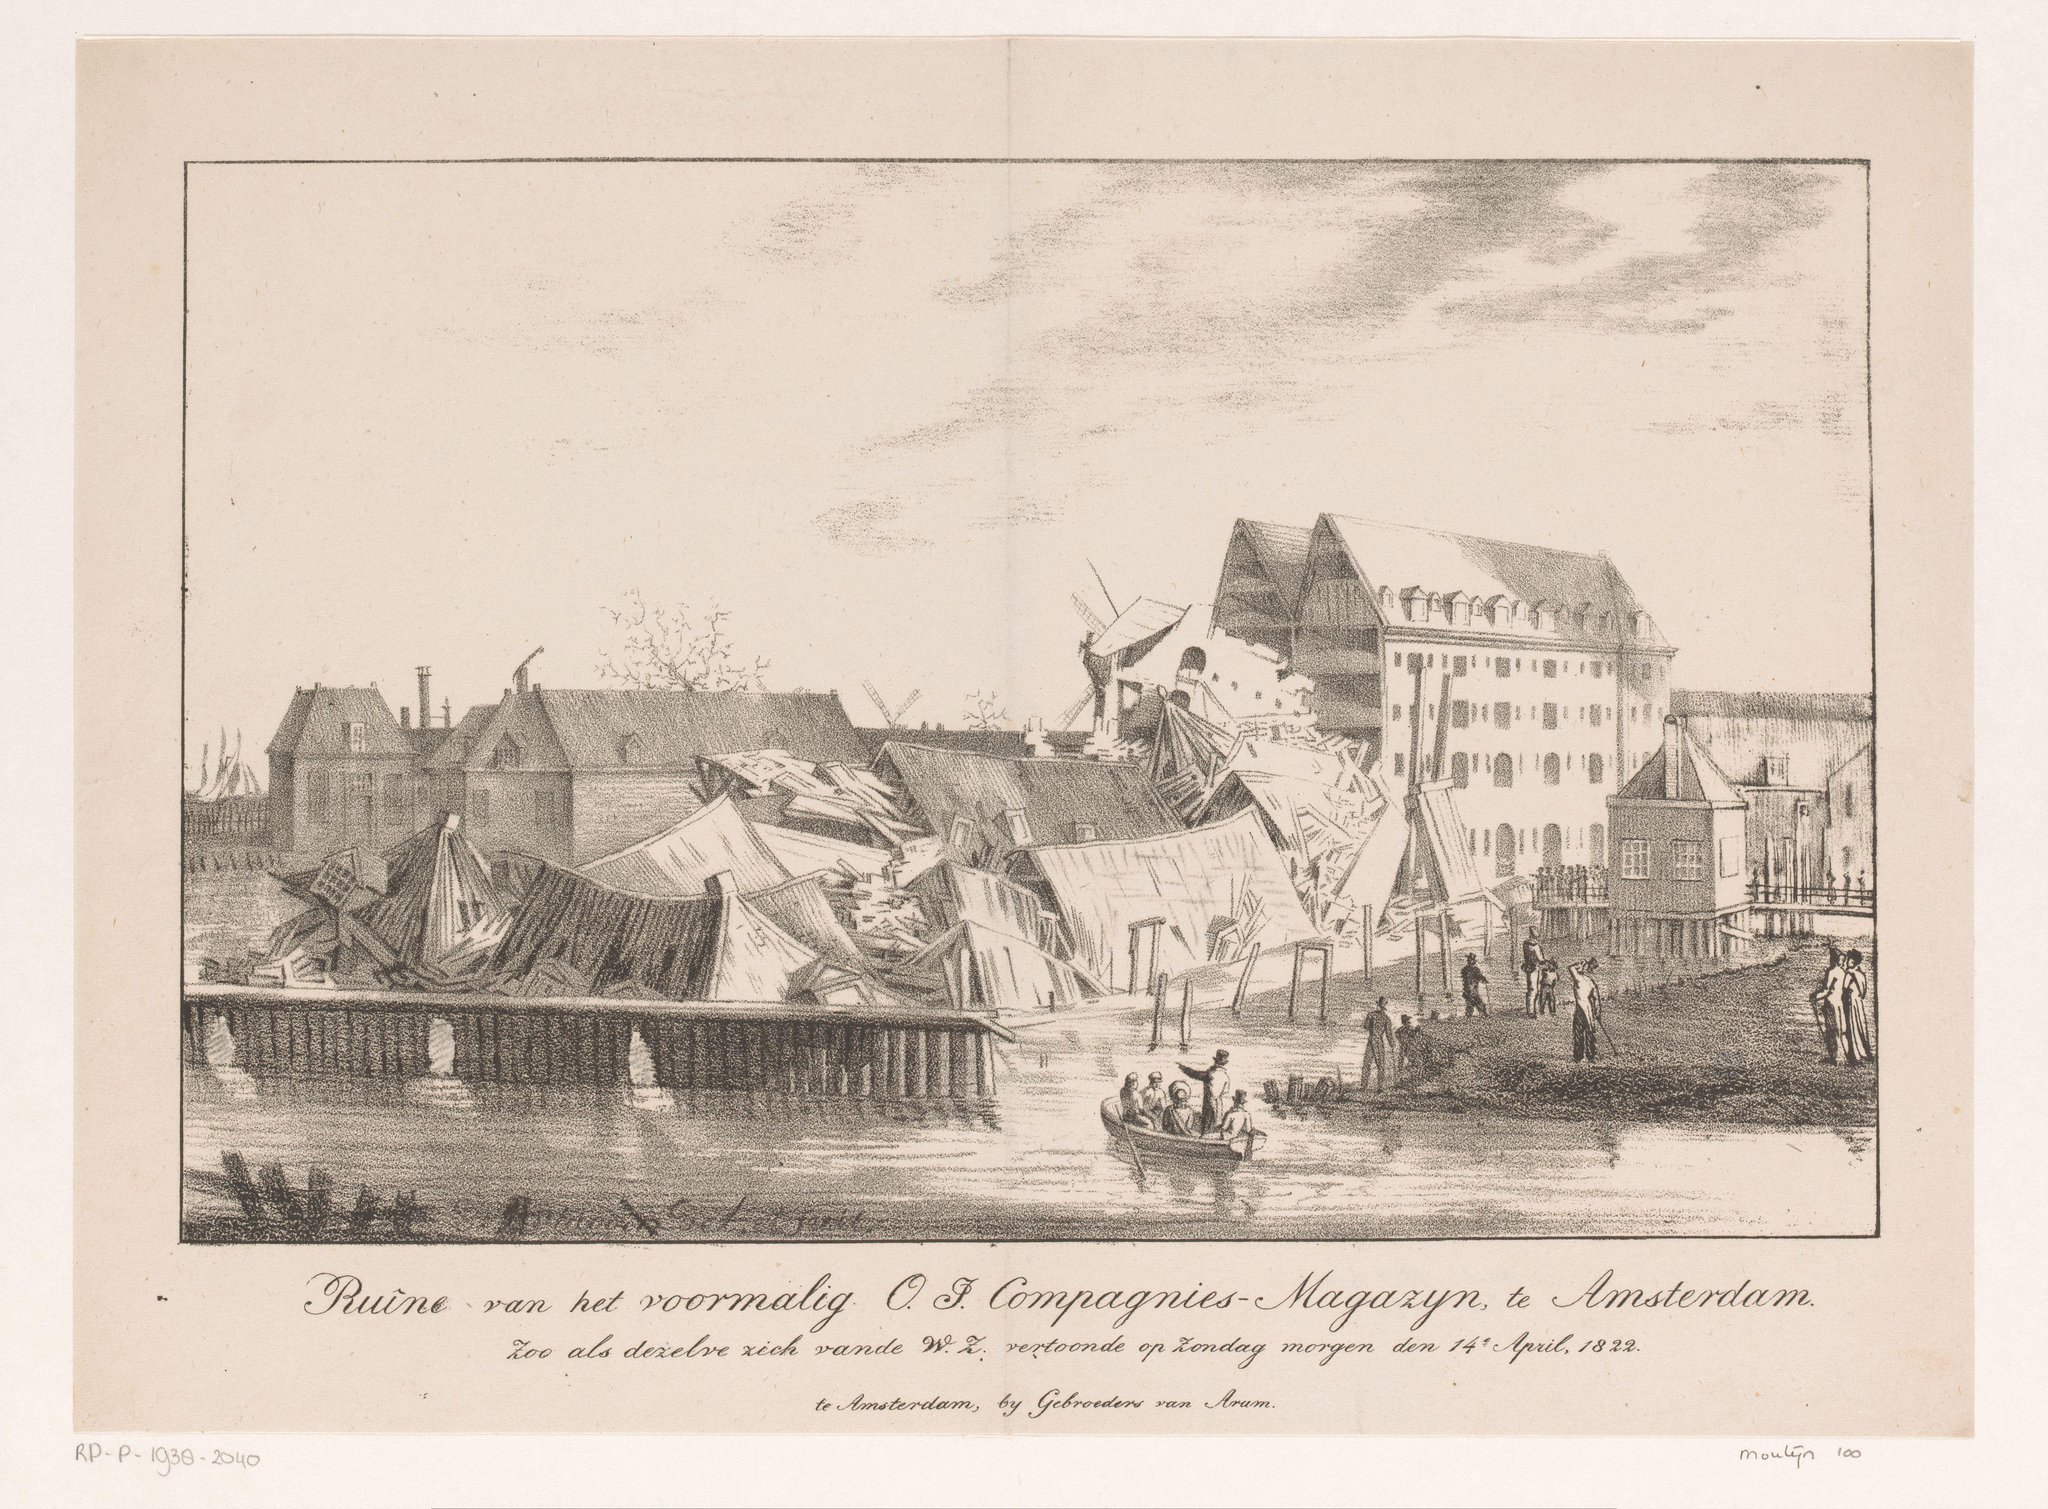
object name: print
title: Gezicht op het IJ te Amsterdam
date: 1822-1824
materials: paper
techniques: lithograph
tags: sailing-ship, sailing-boat, amsterdam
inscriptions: collector's mark: Lugt 2228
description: Figuren in een zeilboot en twee roeiboten varen op het IJ. In de achtergrond liggen zeilschepen in de haven.